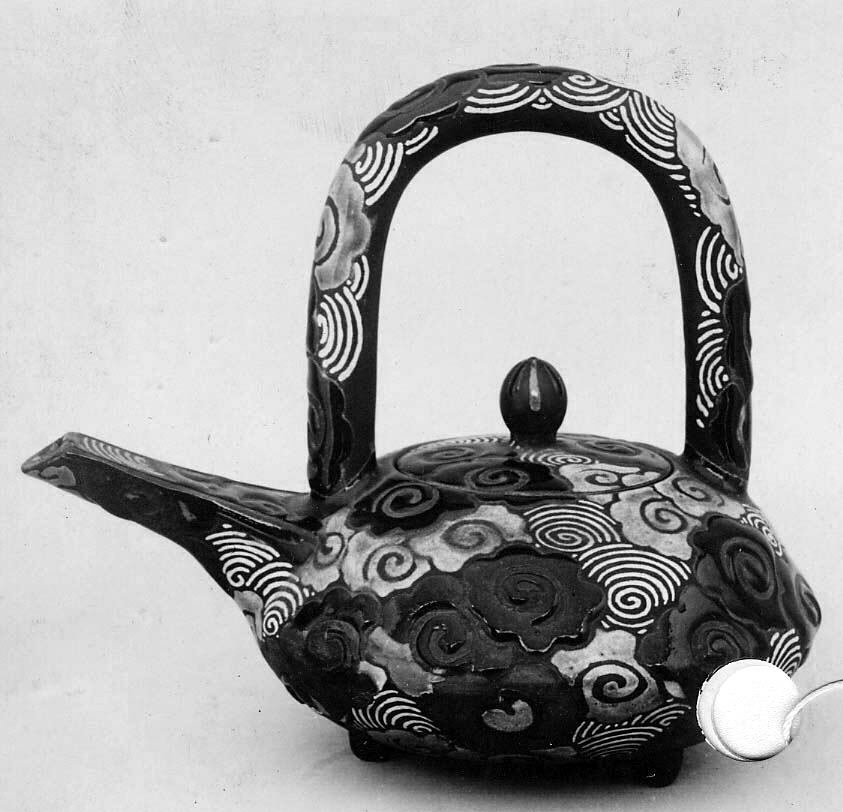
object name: wine pot with cover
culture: japanese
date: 1801-1900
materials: enamel, paste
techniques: polychrome